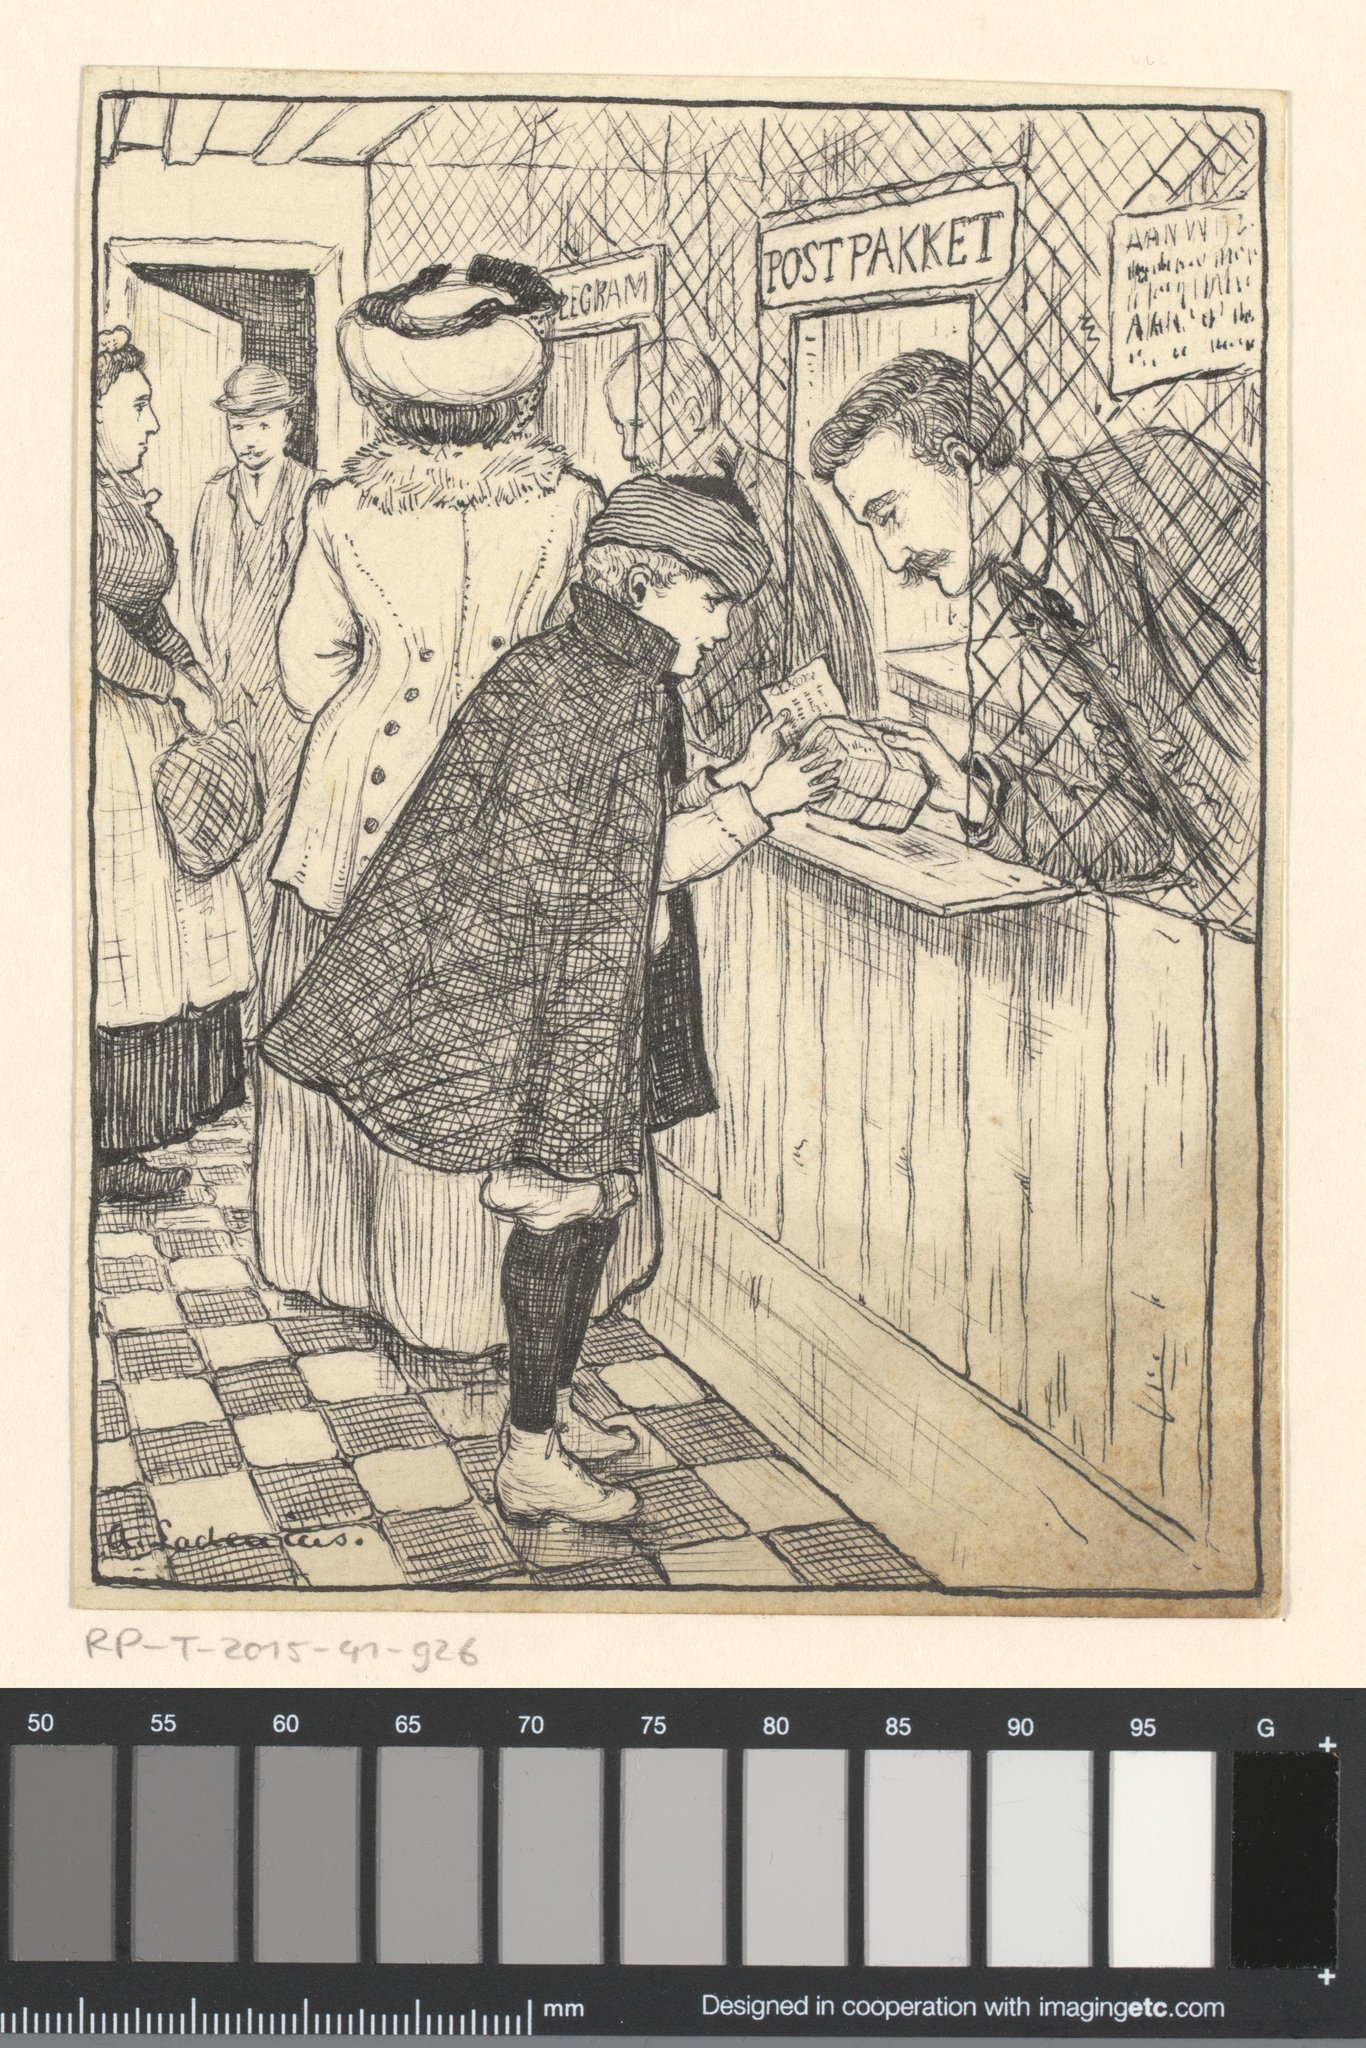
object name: drawing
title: Jongen met pakket bij een postloket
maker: adri ladenius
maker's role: draughtsman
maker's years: 1883-1953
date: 1893-1953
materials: ink, paper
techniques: pen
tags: post-office, boy (child between toddler and youth), sending and receiving postal matter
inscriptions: number: ‘2/’, collector's mark: Lugt 2228, signature: ‘A. Ladenius’, :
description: Een jongen in een cape staat bij het loket voor postpakketten in een postkantoor. Hij heeft een pakket en een brief in zijn hand.